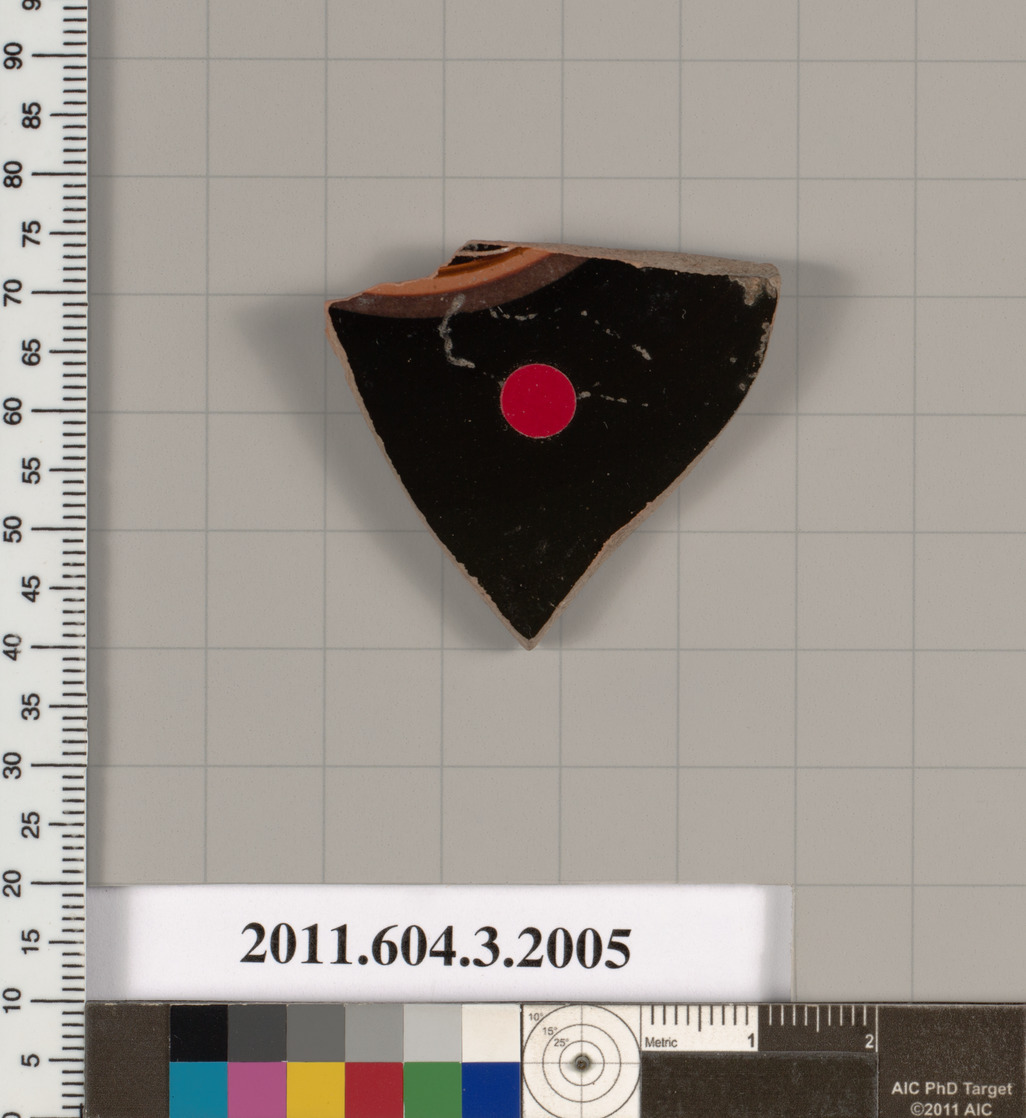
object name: kylix fragment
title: Terracotta fragment of a kylix (drinking cup)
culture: greek, attic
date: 550-526 BCE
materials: terracotta